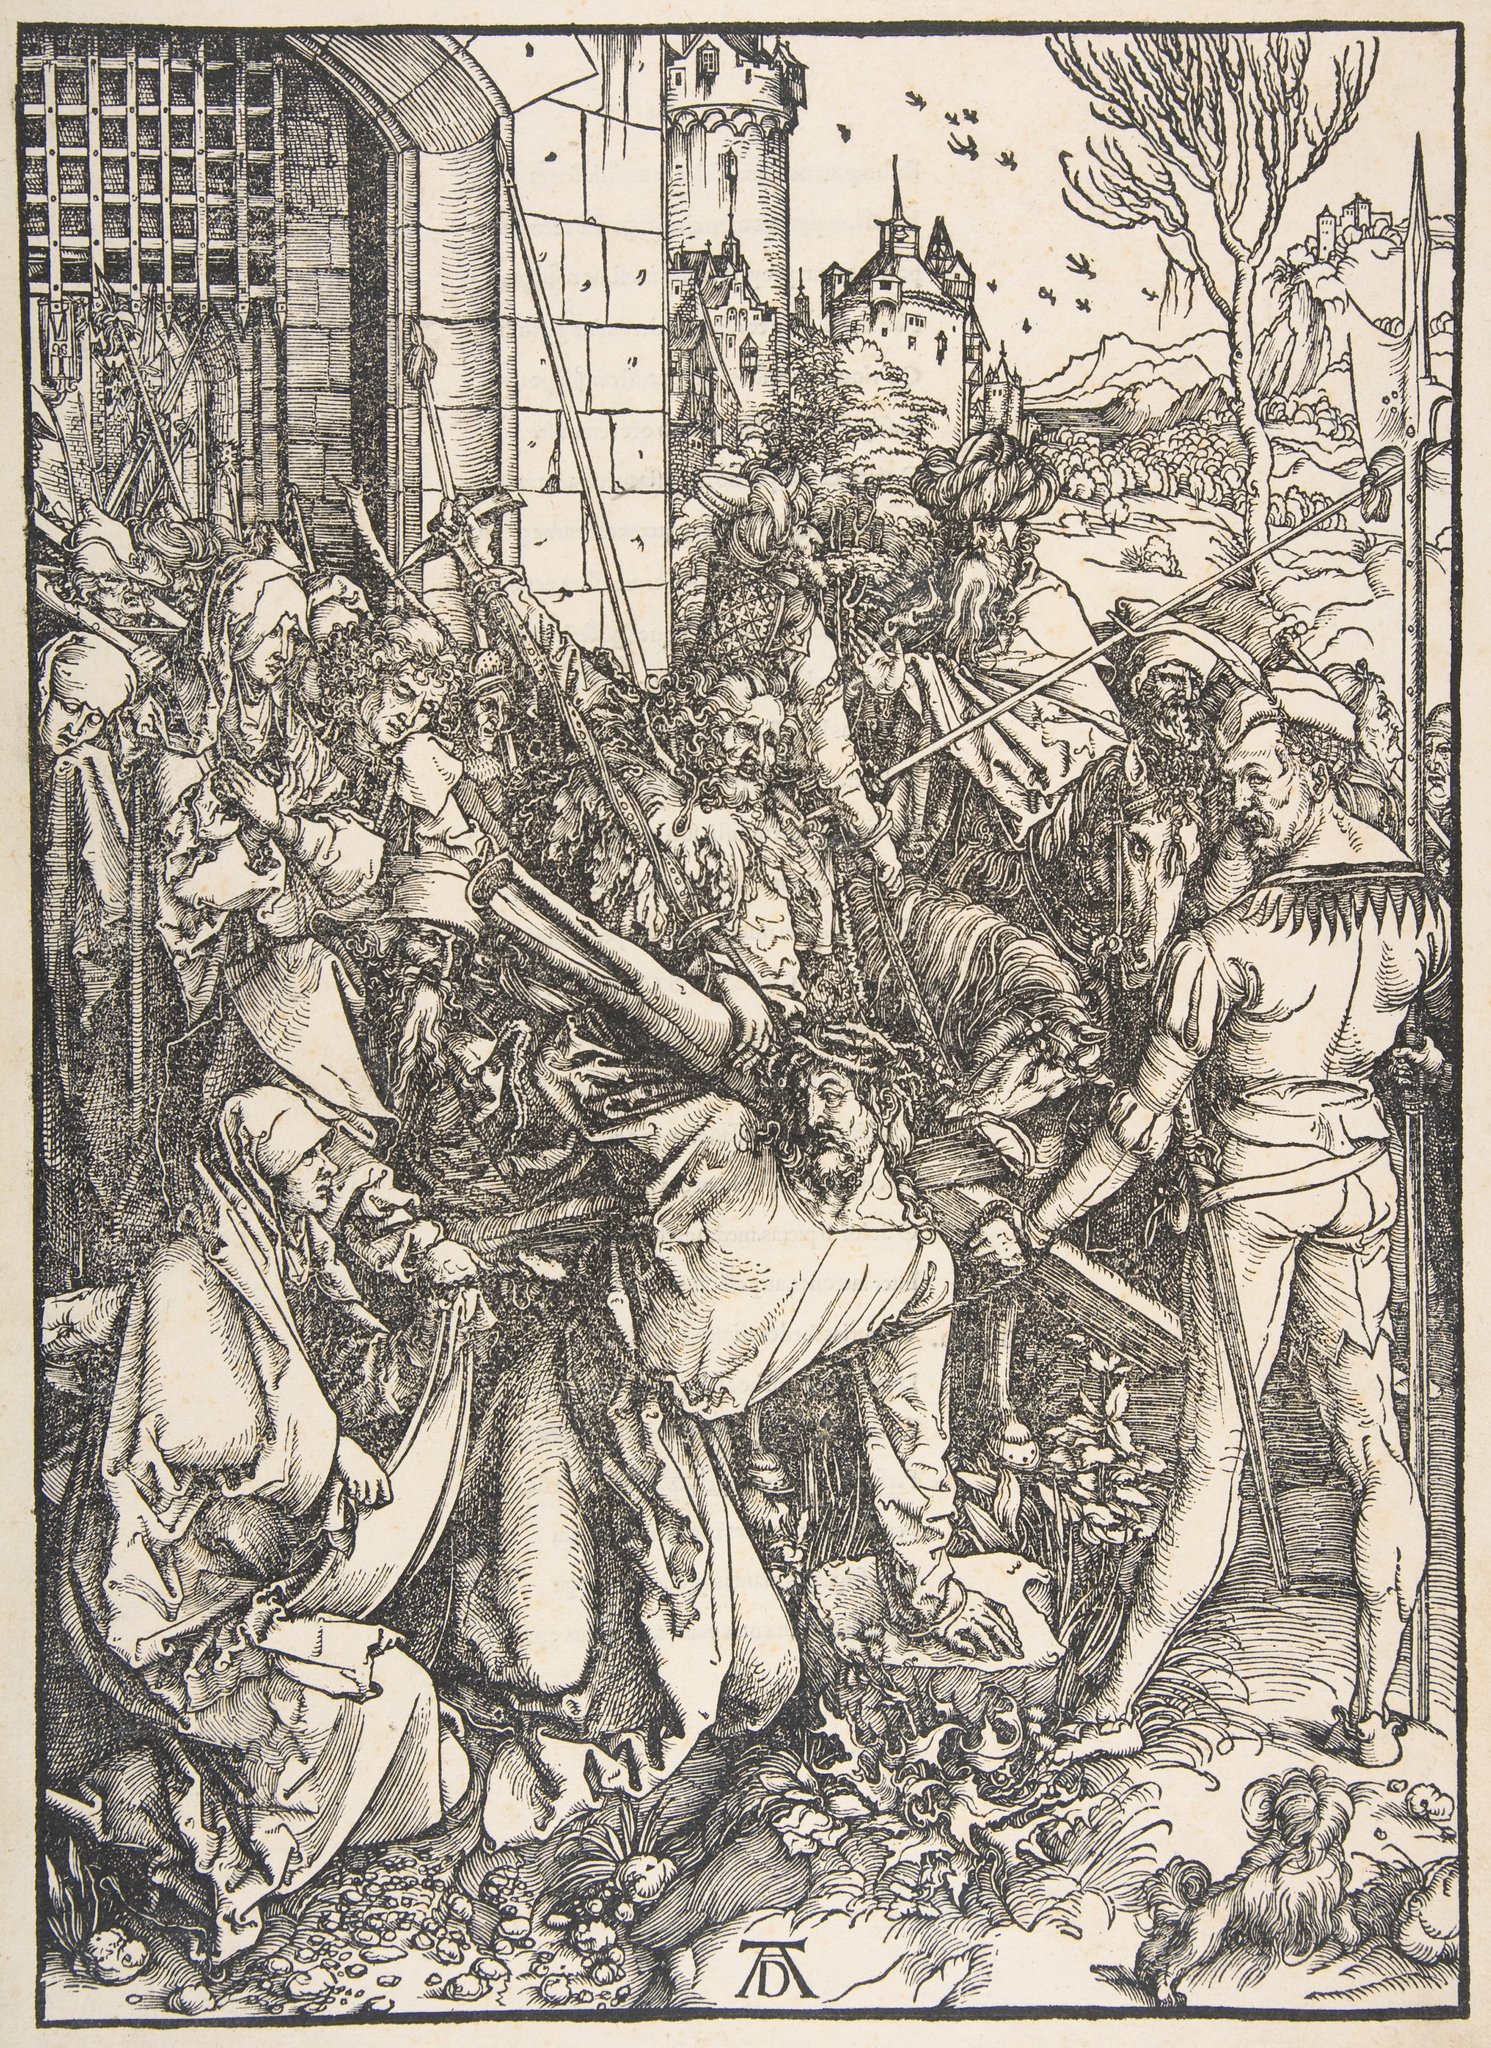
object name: print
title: The Bearing of the Cross, from "The Large Passion"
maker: albrecht dürer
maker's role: artist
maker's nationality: german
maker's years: 1471-1528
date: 1511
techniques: woodcut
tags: suffering,men,women,christ